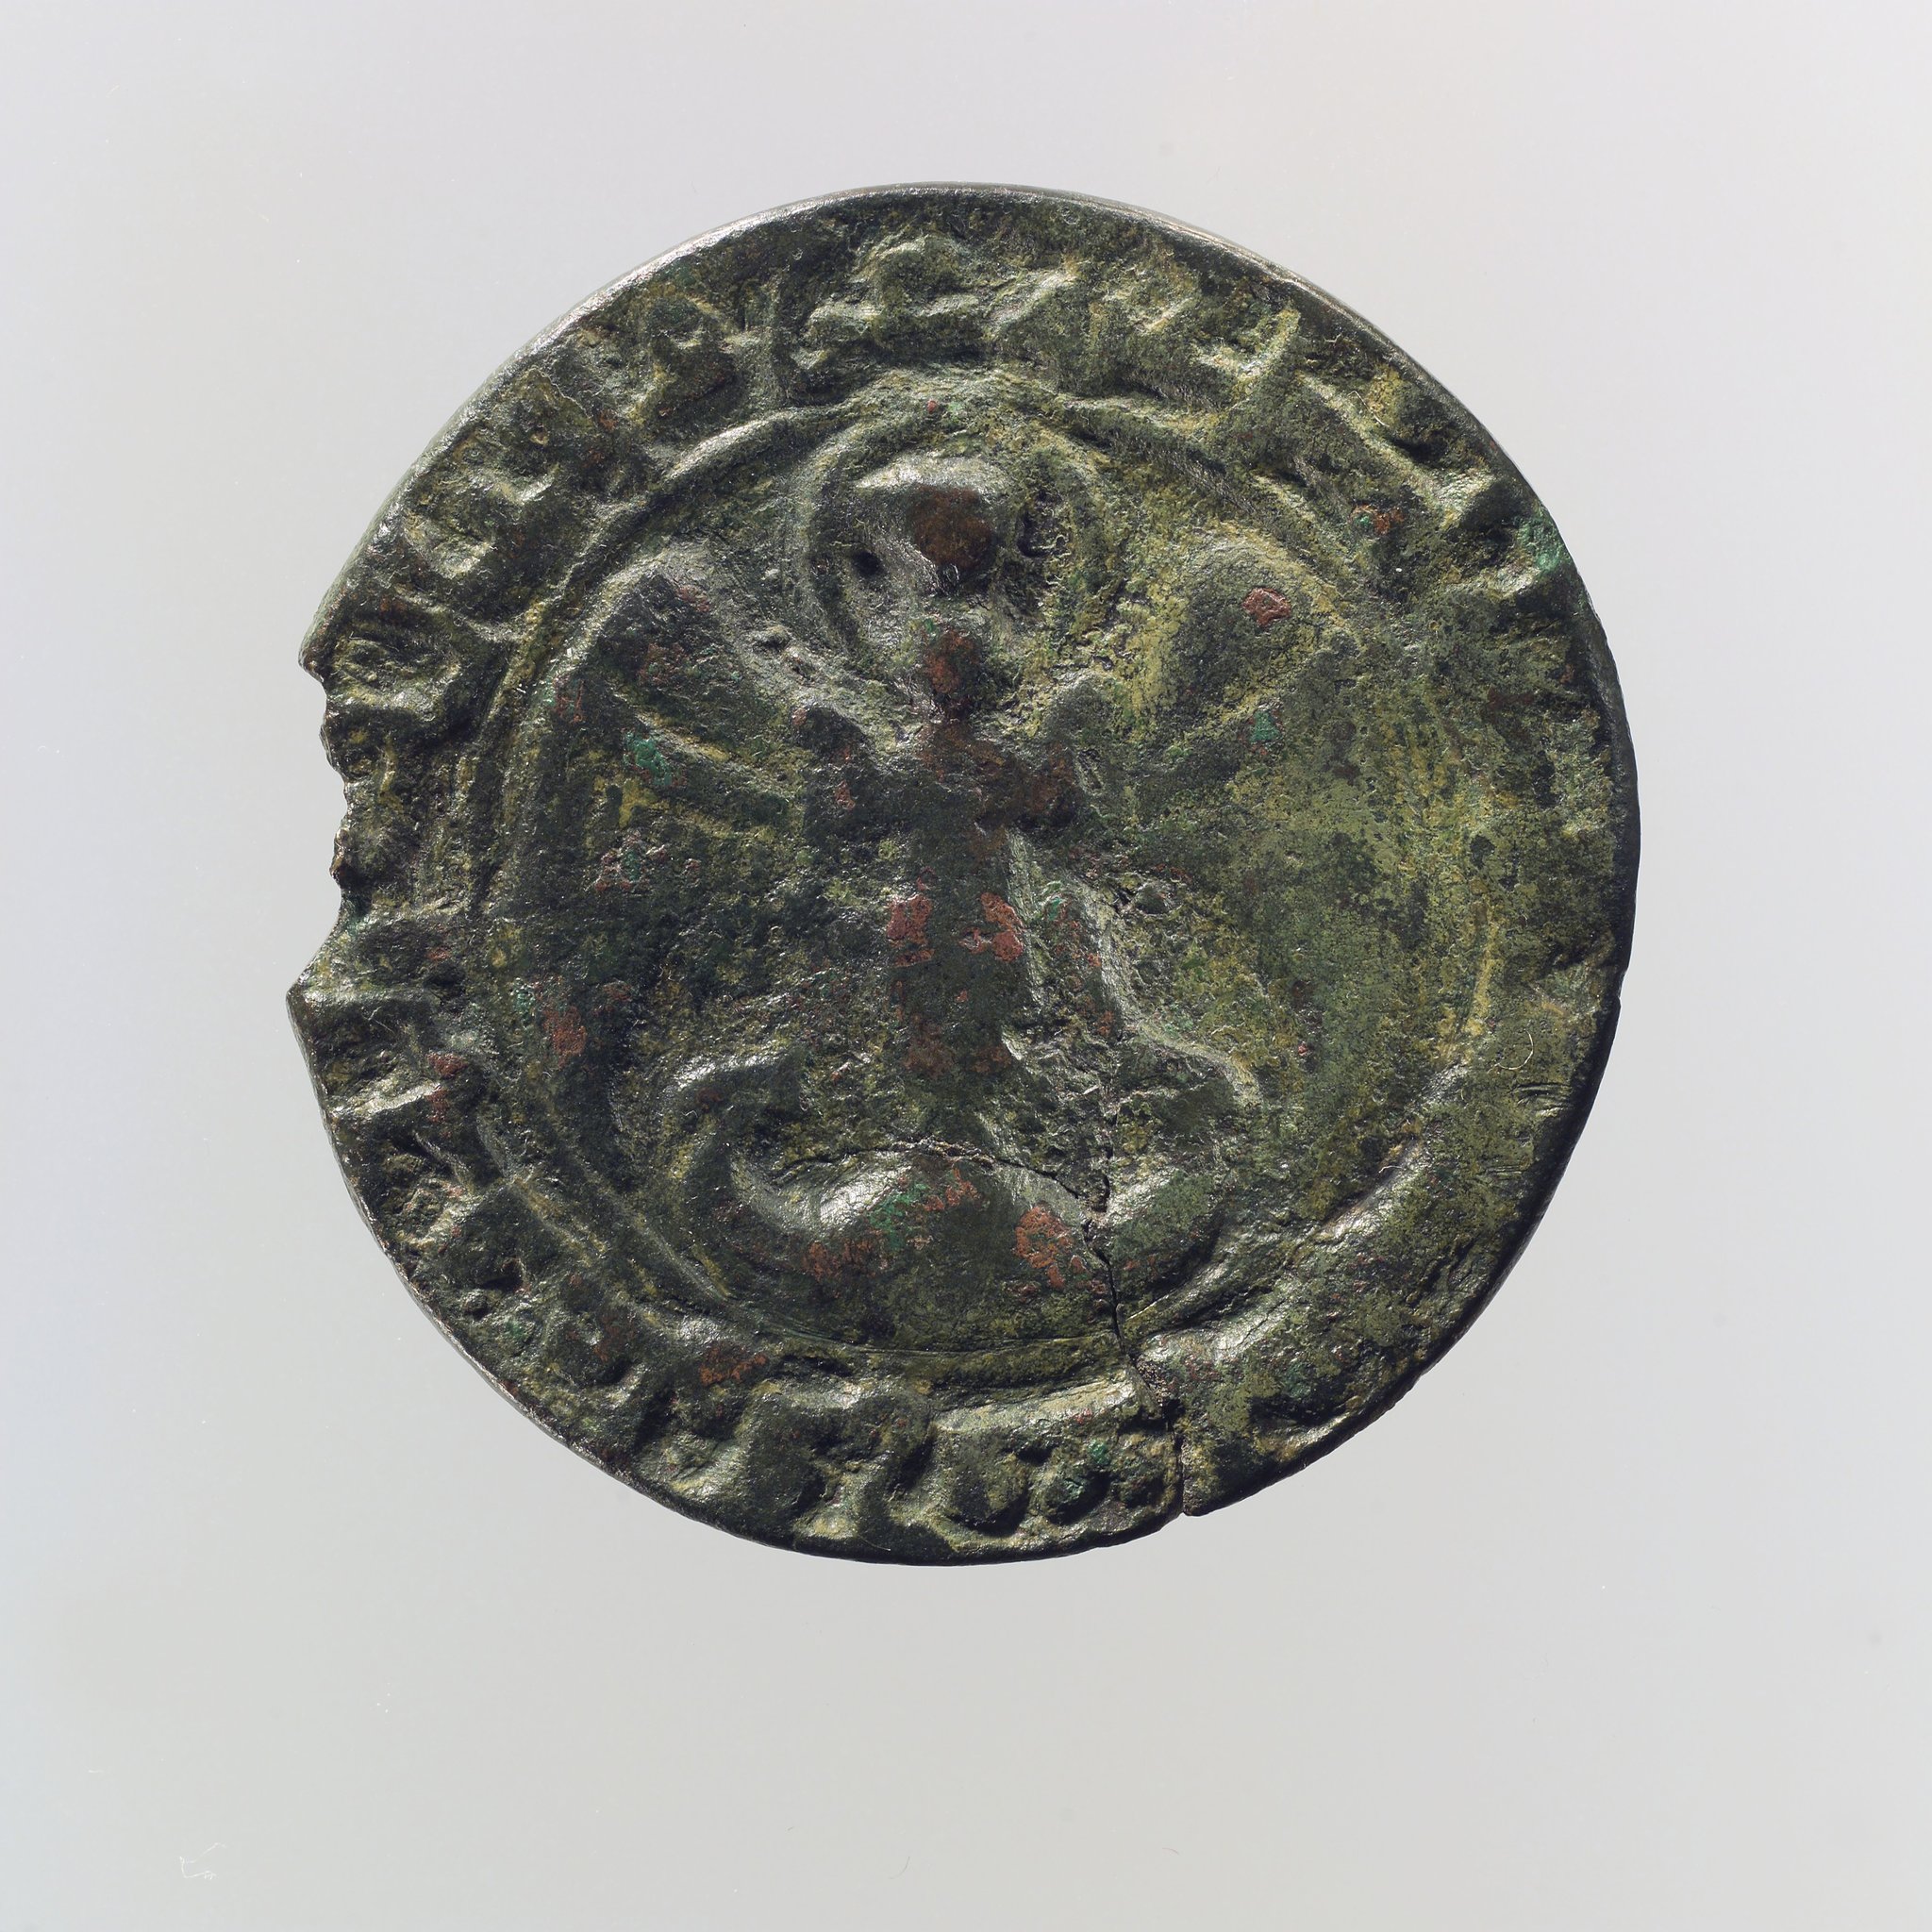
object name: mirror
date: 1101-1200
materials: bronze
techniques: casting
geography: afghanistan